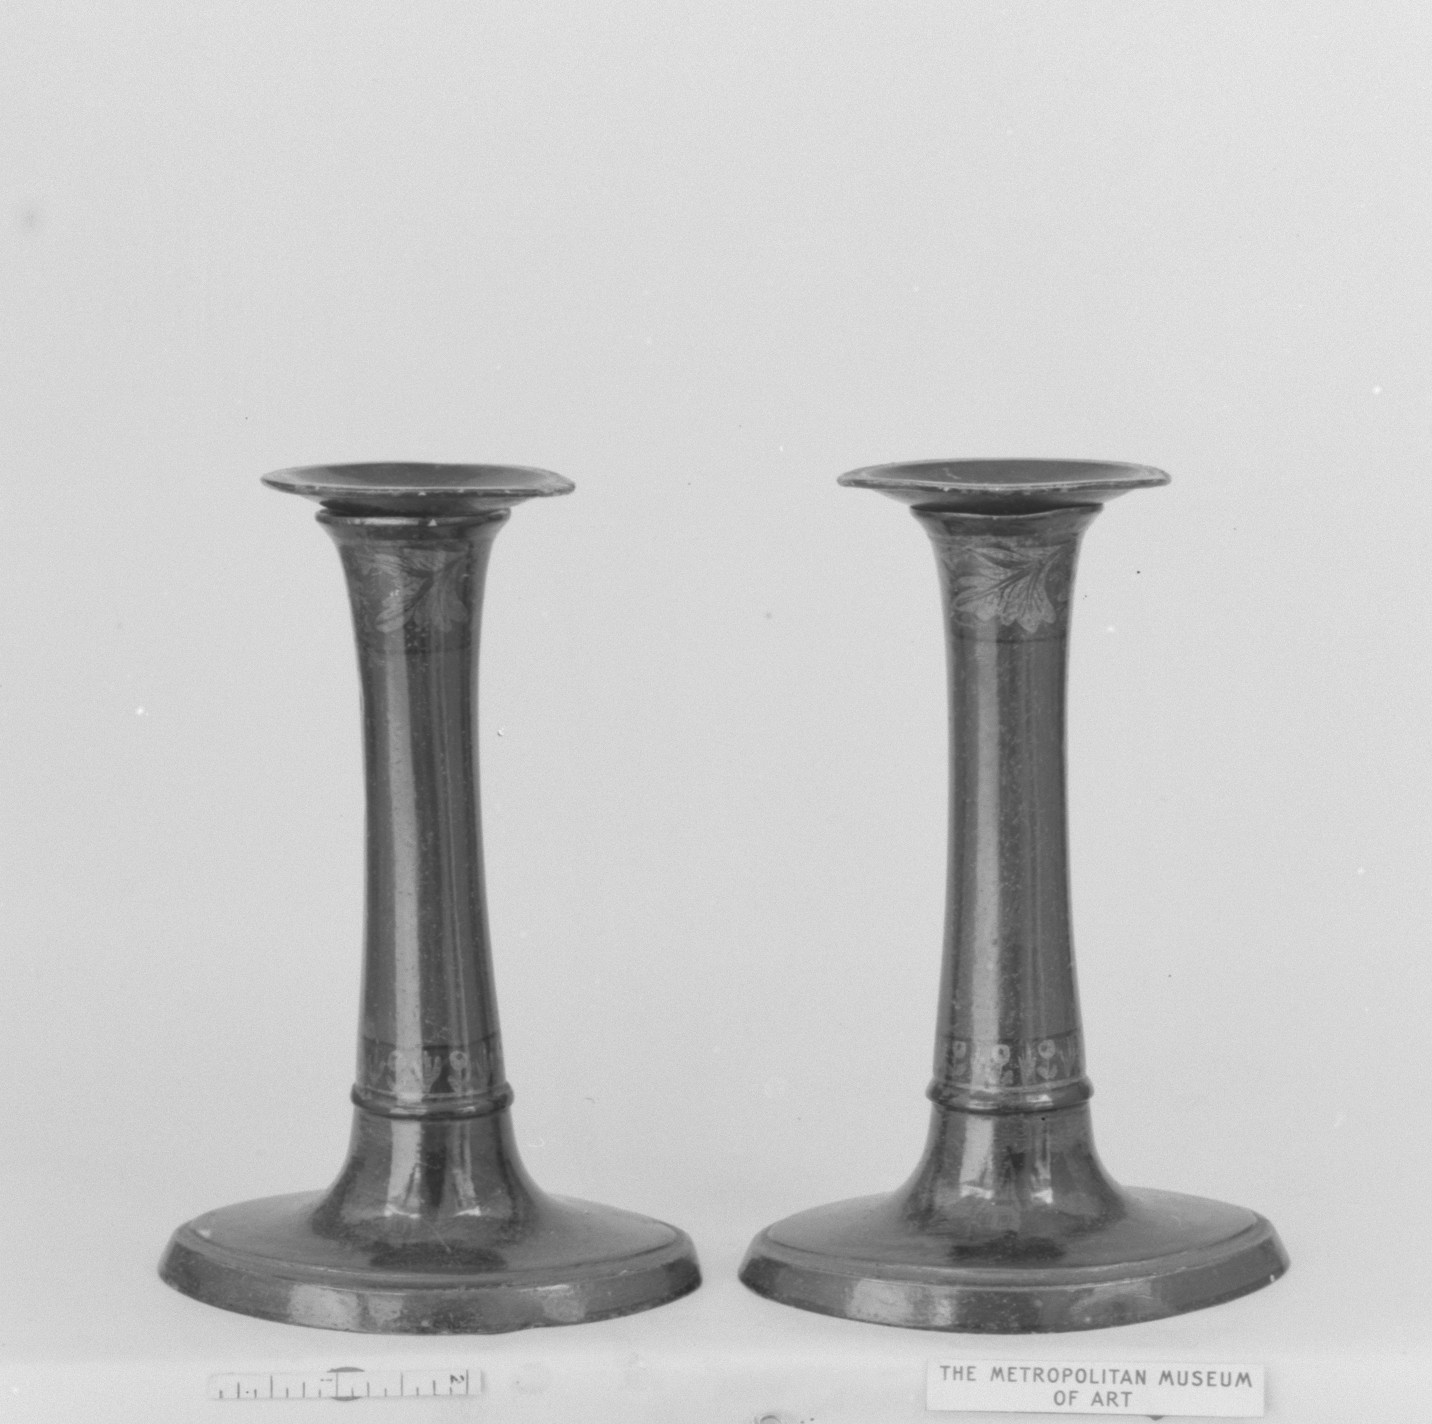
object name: candlestick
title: Pair of candlesticks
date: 1801-1900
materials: pewter